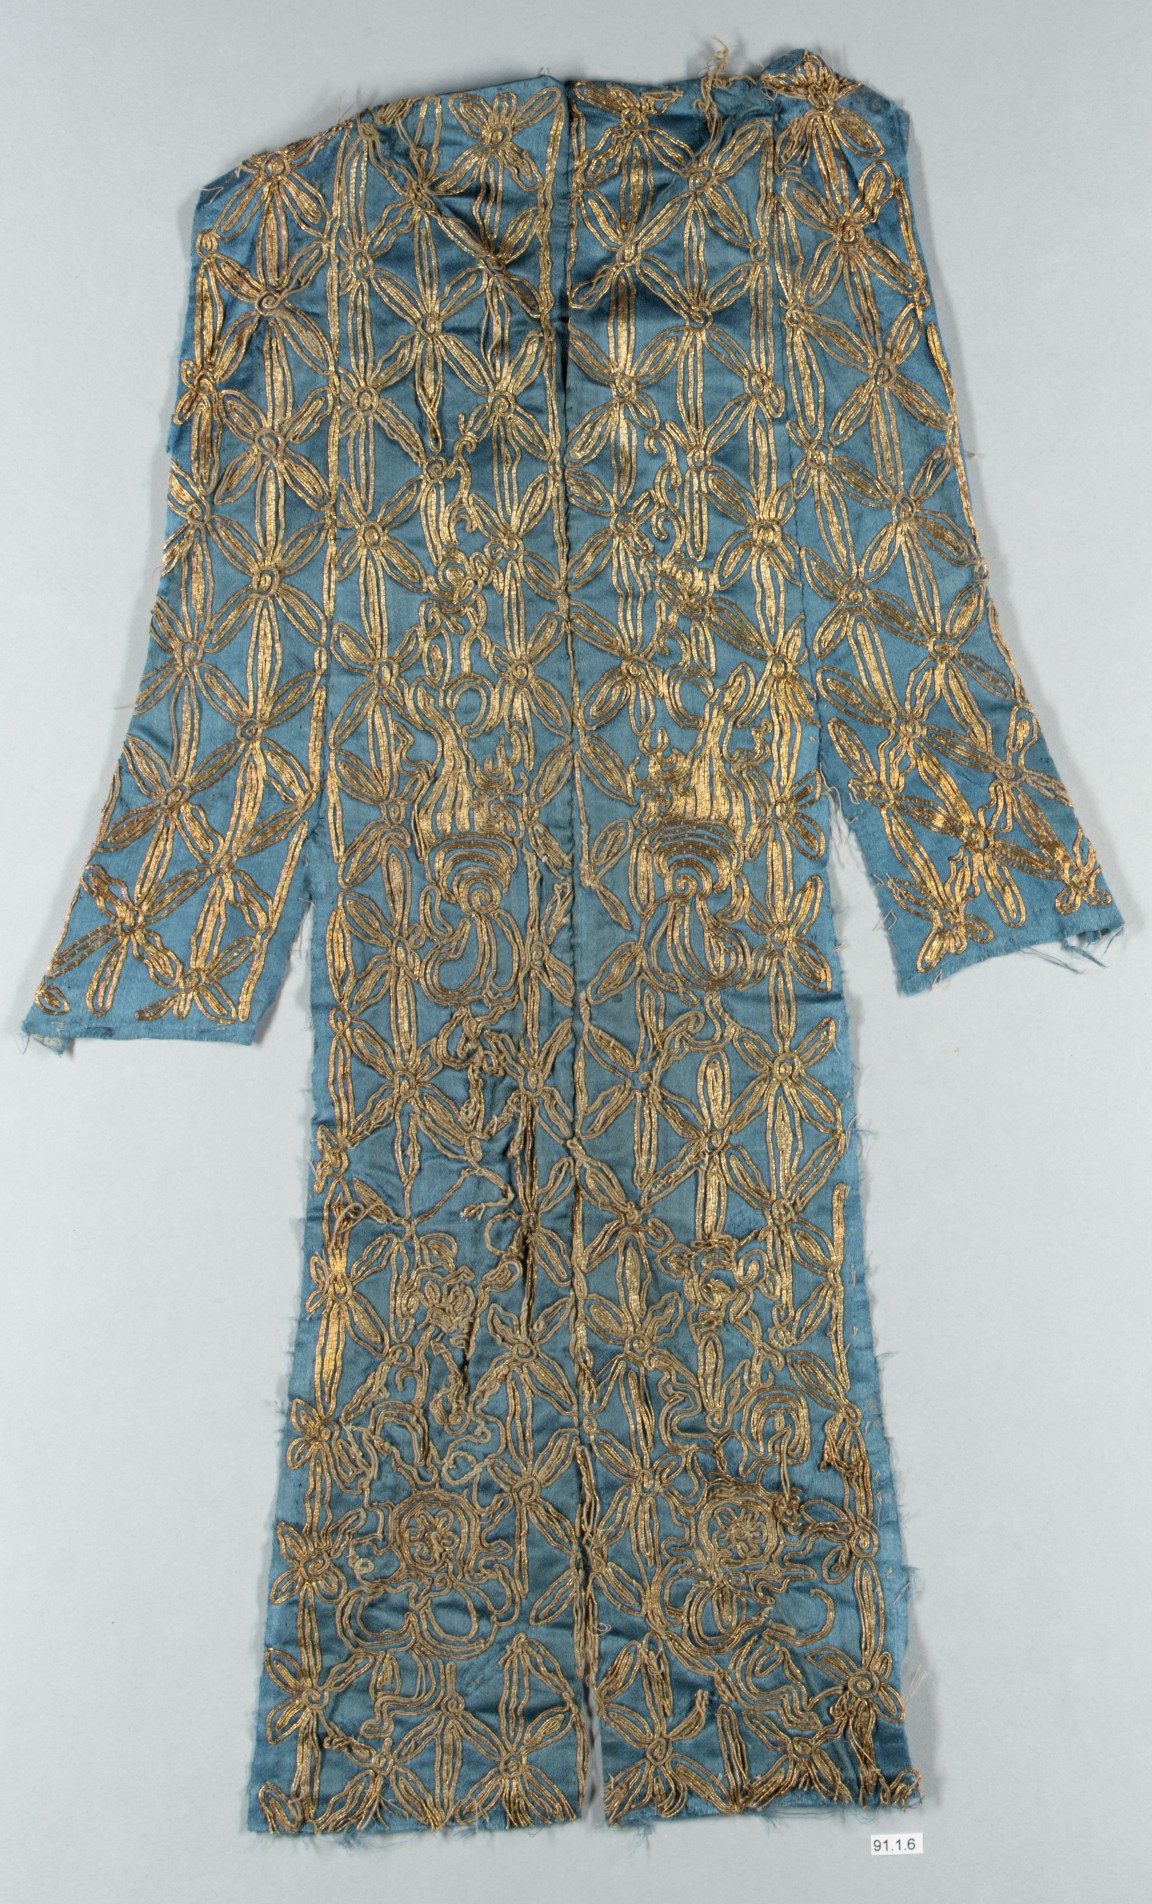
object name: costume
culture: japanese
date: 1801-1900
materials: metal thread, silk